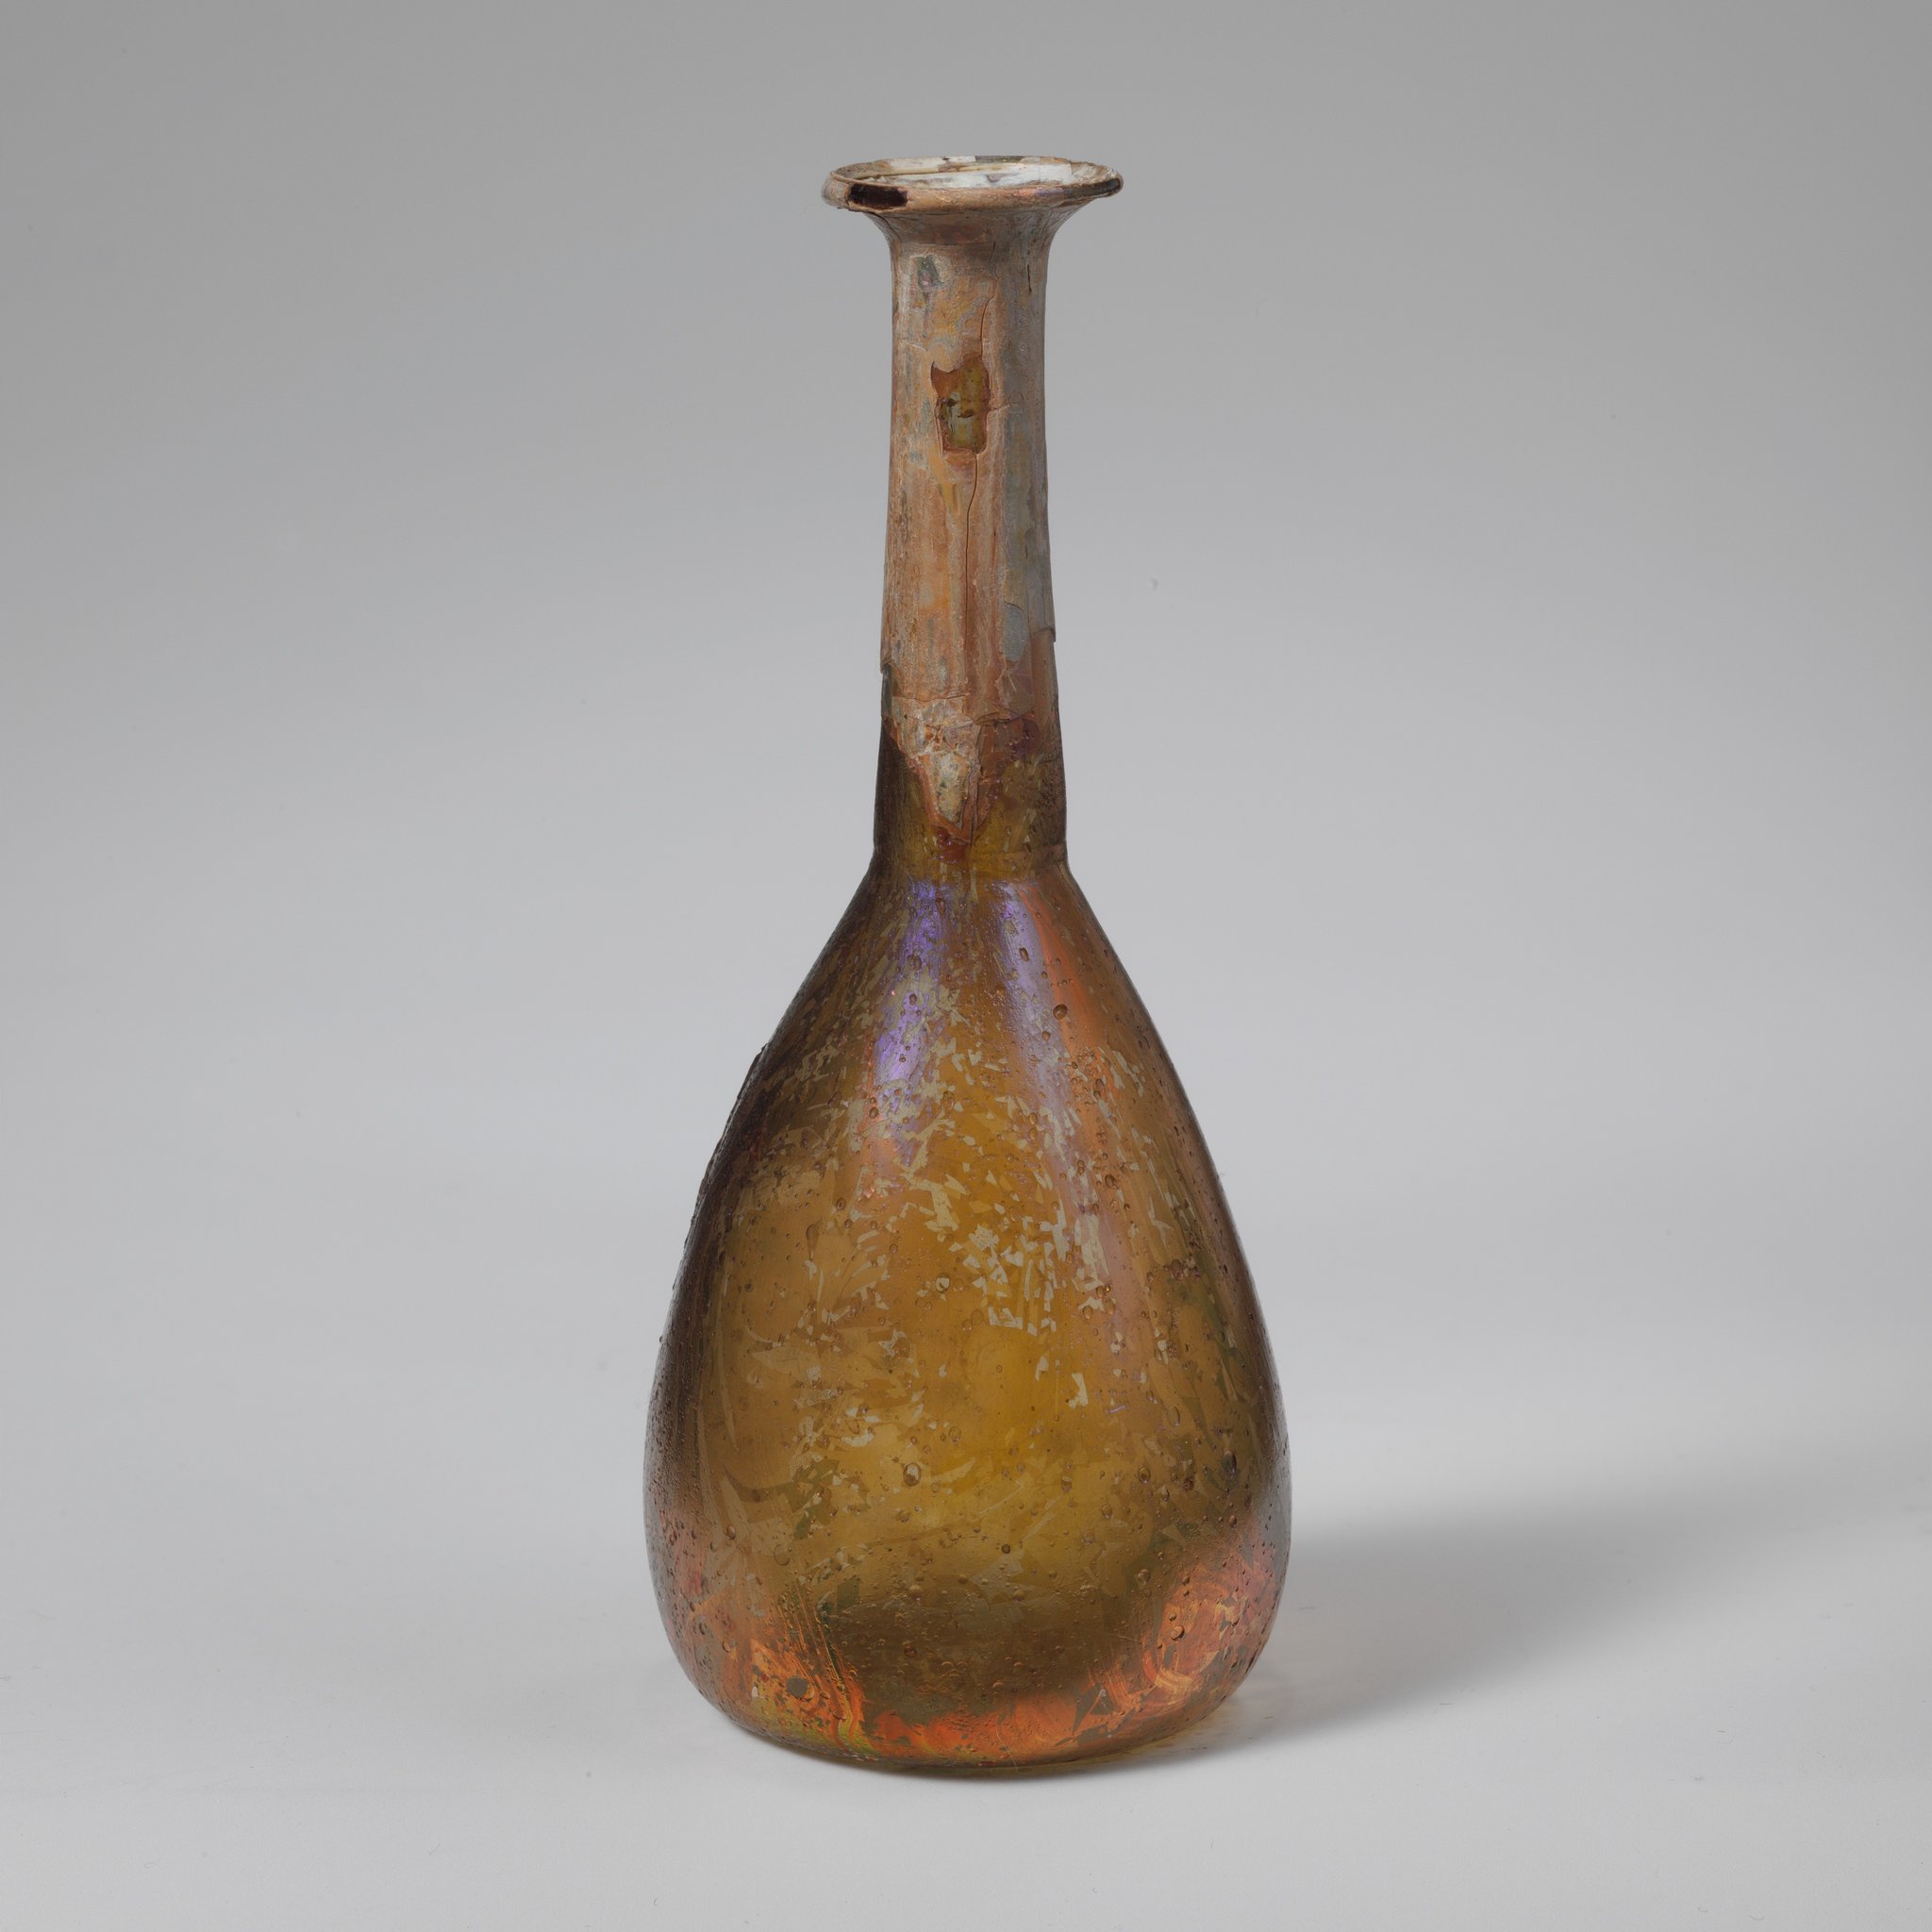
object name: perfume bottle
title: Glass perfume bottle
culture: roman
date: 1-100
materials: glass